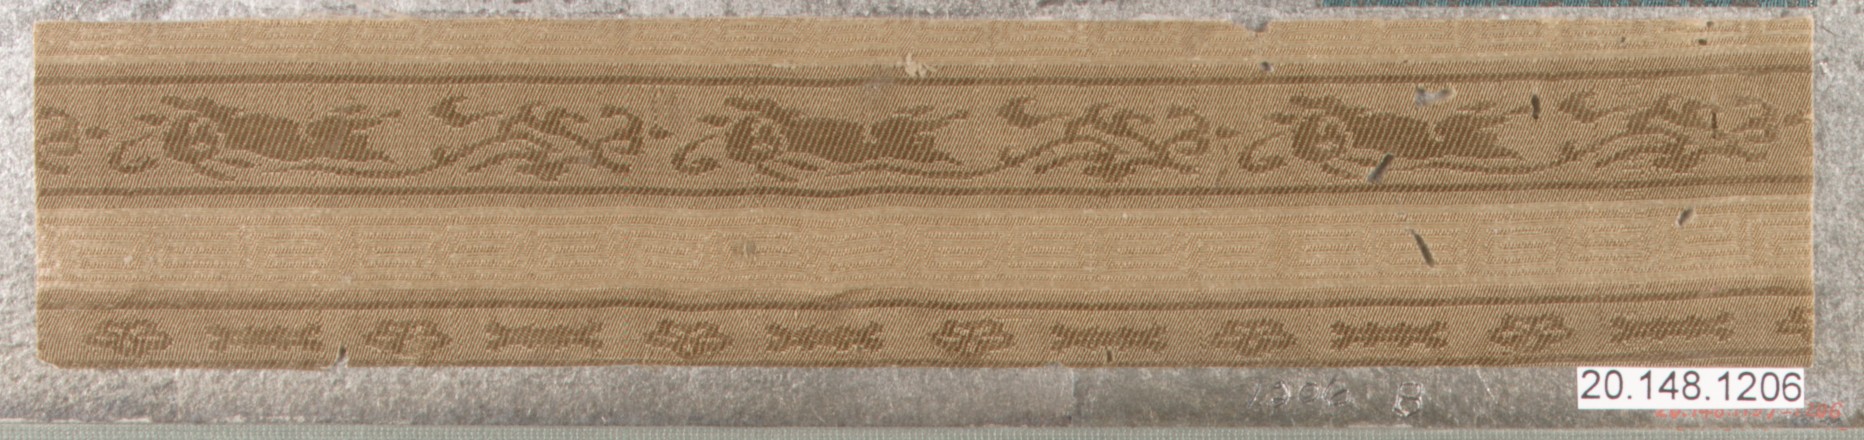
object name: piece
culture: japanese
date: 1701-1800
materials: silk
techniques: compound weave